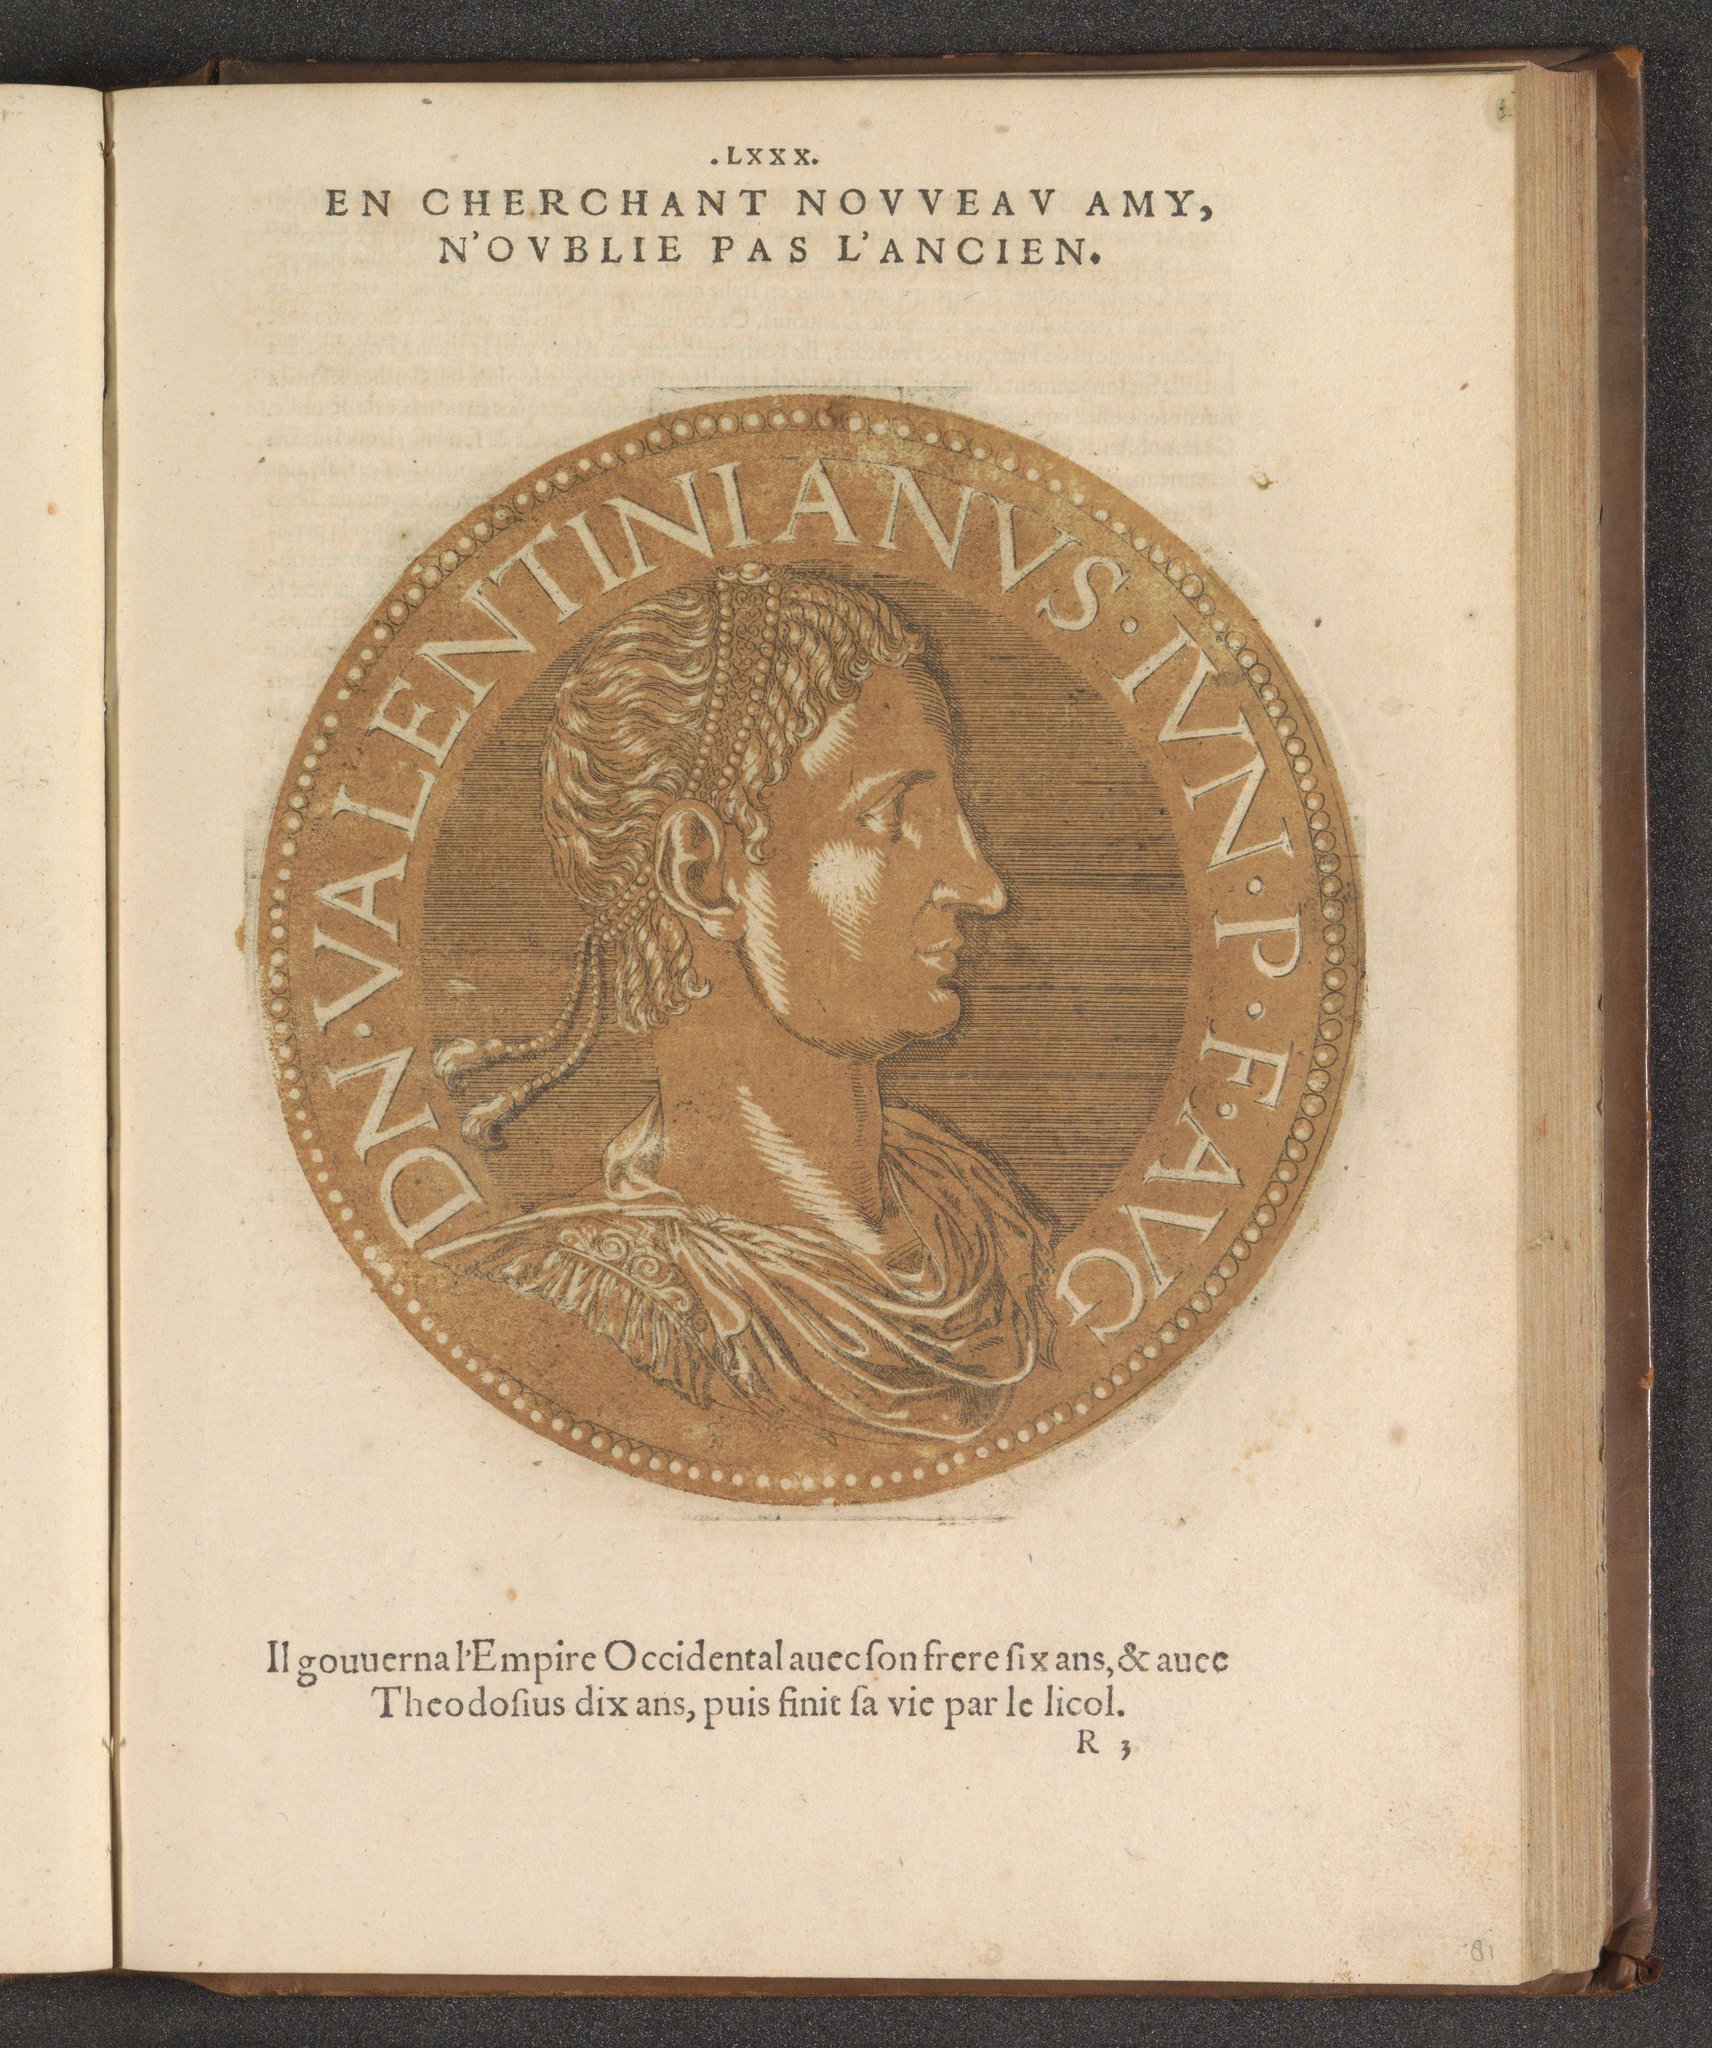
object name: print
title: Les images presque de tous les empereurs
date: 1557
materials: paper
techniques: woodcut, etching, letterpress printing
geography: antwerp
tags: emperor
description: Portret van keizer Valentinianus II, op een munt met randschrift. De prent maakt deel uit van een boek over de keizers vanaf Julius Caesar tot en met Karel V en zijn broer Ferdinand.